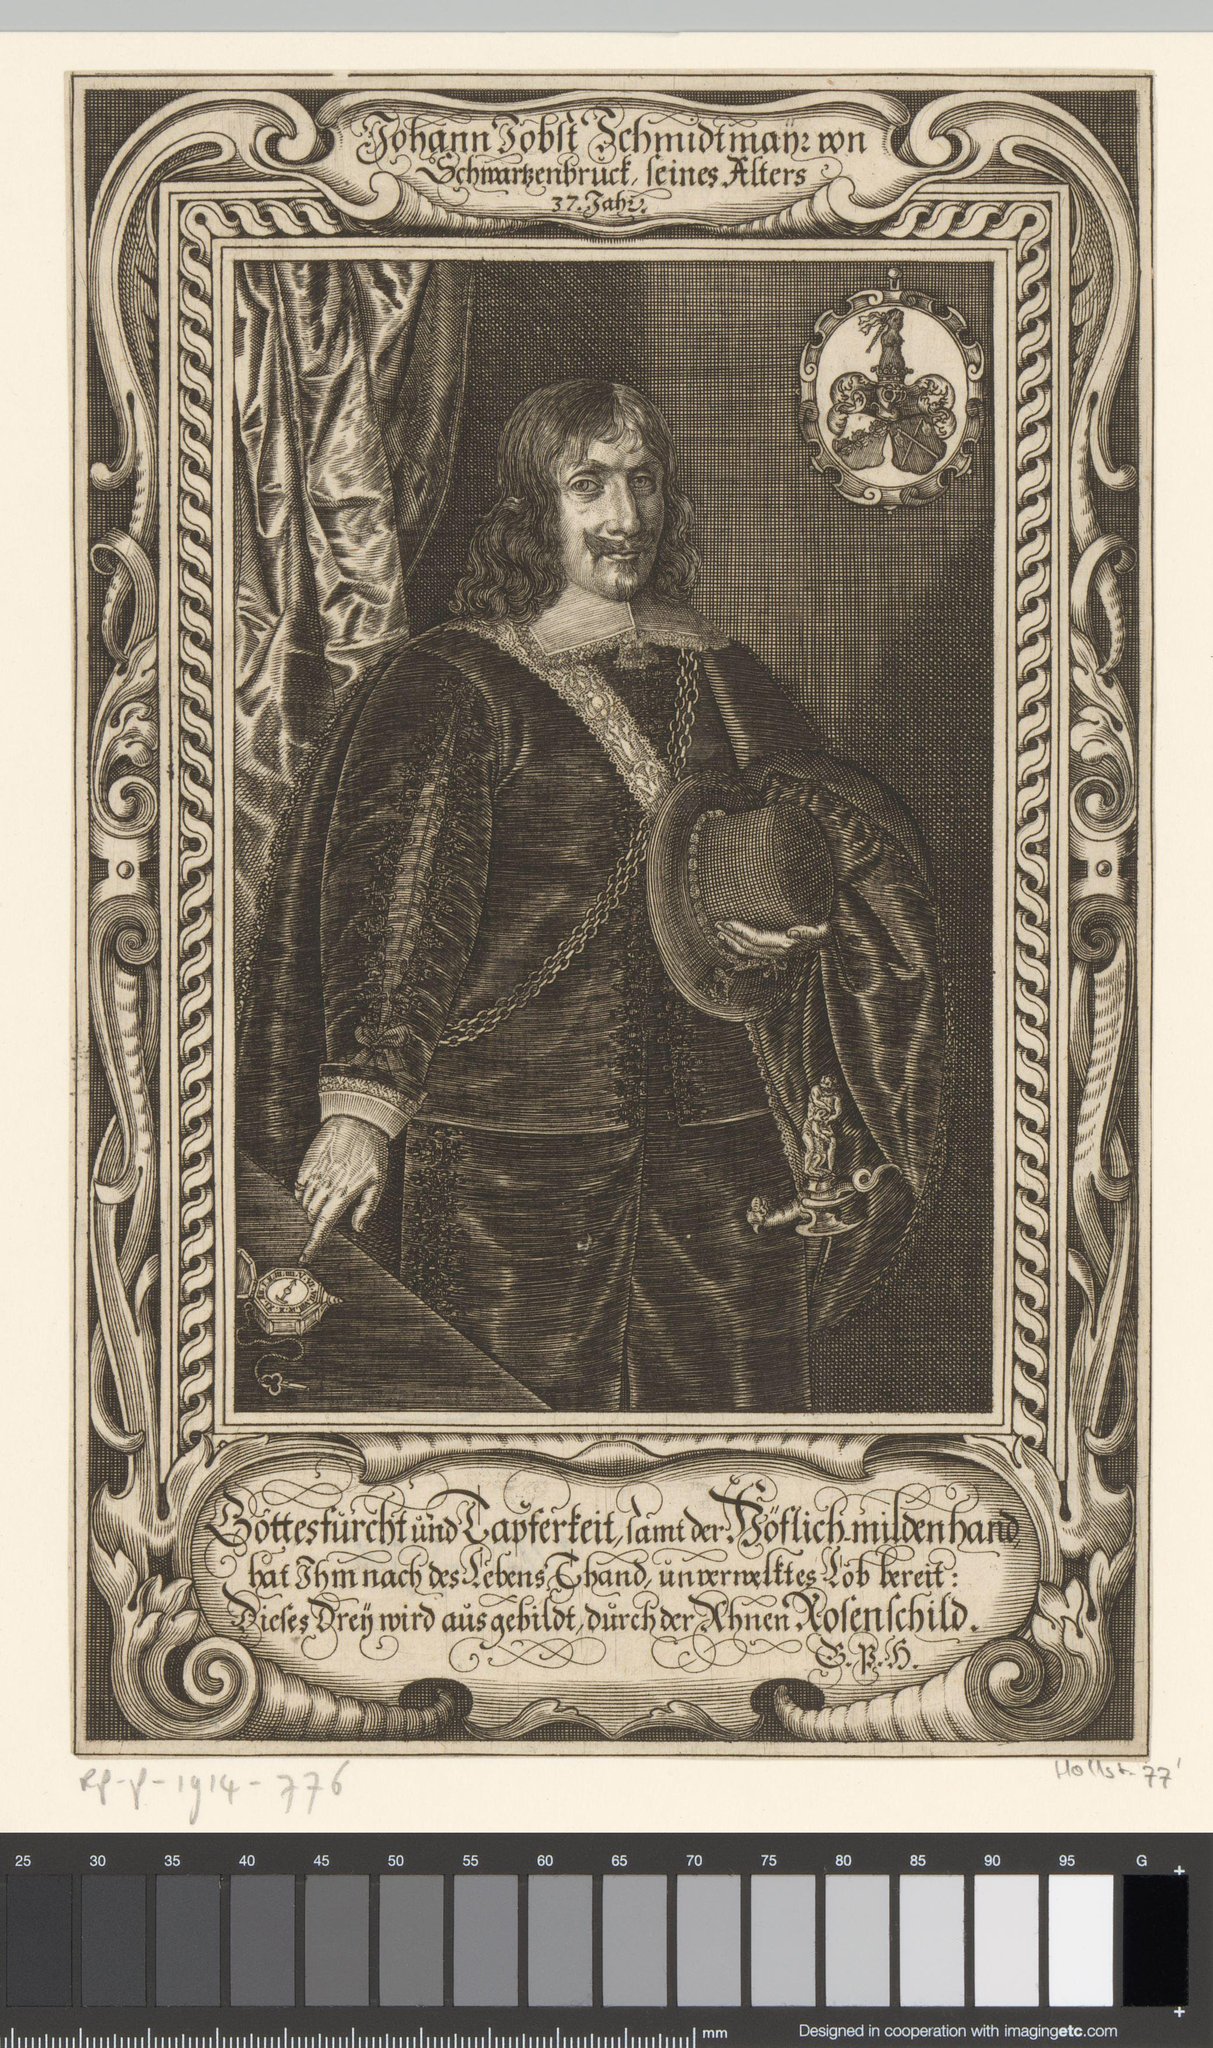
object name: print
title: Portret van Johann Jodocus Schmidmair von Schwarzenbruck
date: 1648-1663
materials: paper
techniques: engraving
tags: historical persons, hacking and thrusting weapons: sword, watch, armorial bearing, heraldry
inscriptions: collector's mark: Lugt 2228